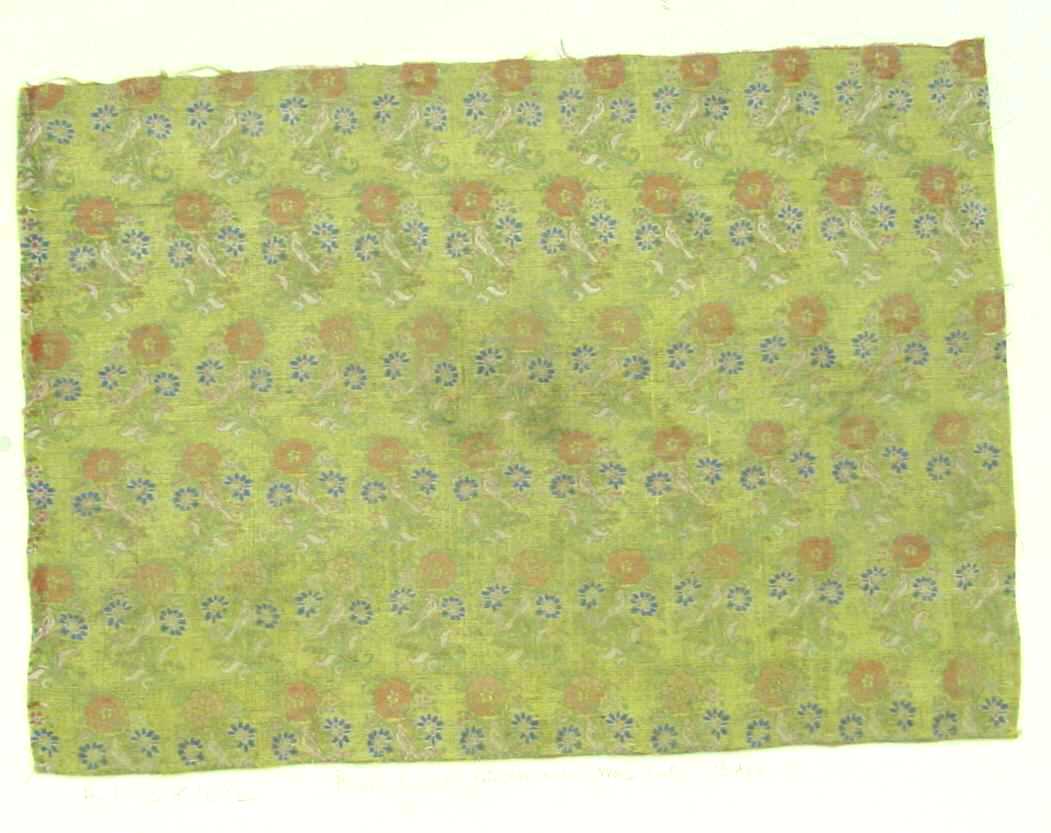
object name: textile fragment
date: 1601-1800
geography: iran